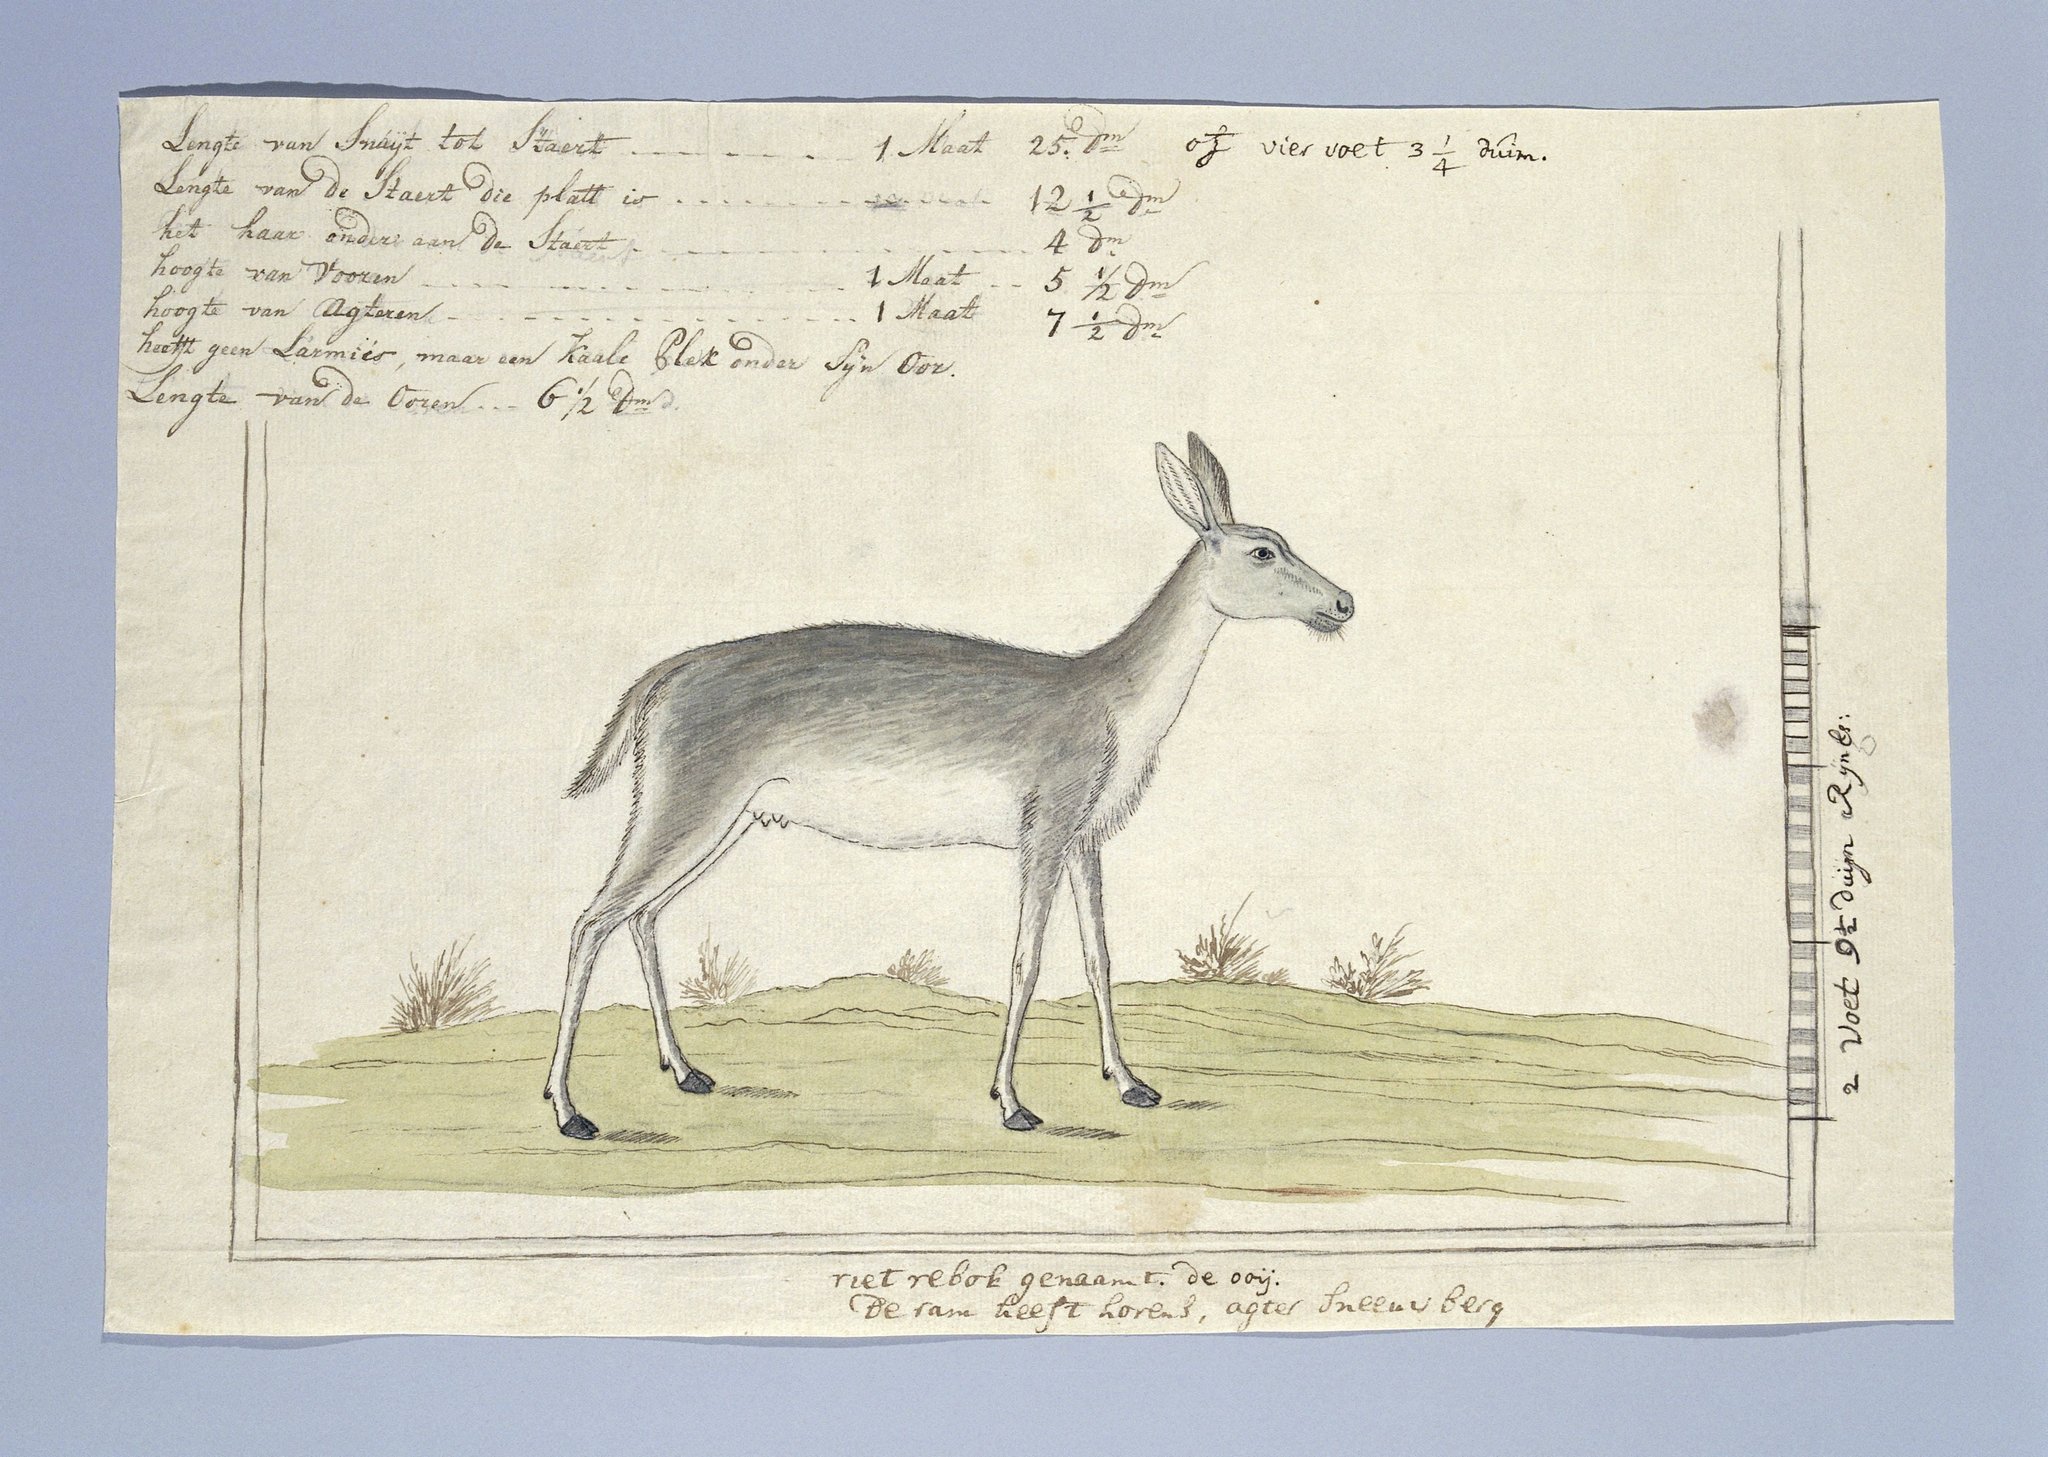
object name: album leaf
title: Redunca arundinum (Southern reedbuck)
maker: robert jacob gordon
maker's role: draughtsman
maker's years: 1743-1795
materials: chalk, ink, paper, pencil, watercolor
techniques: brush, pen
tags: animals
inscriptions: annotation: ‘onder: riet rebok genaamt. de ooij. / [...]’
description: Rietreebok, of rode rietbok (Redunca arundinum): de ooi; met schaalverdeling in Rijnlandse maat.